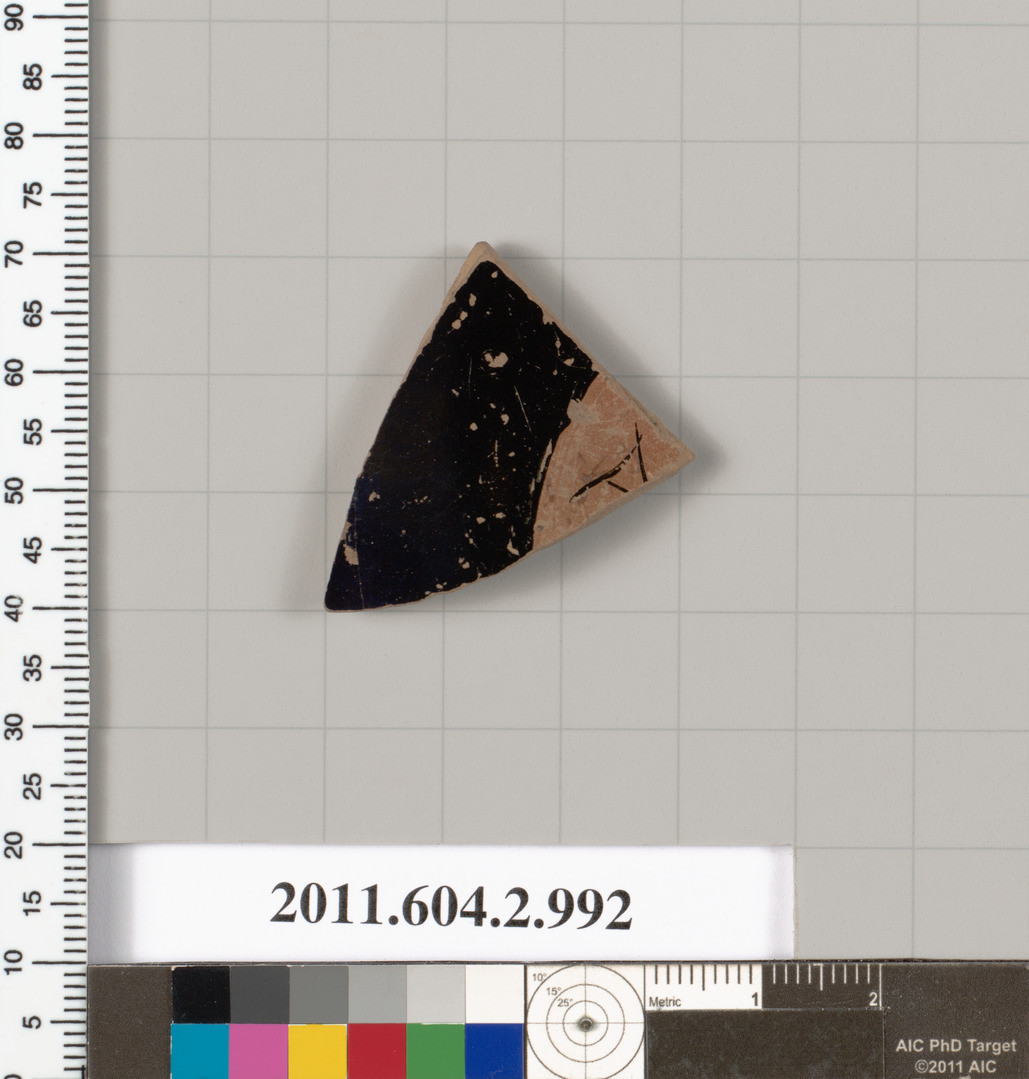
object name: oinochoe fragment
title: Terracotta fragment of an oinochoe (jug)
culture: greek, attic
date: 475-451 BCE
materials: terracotta